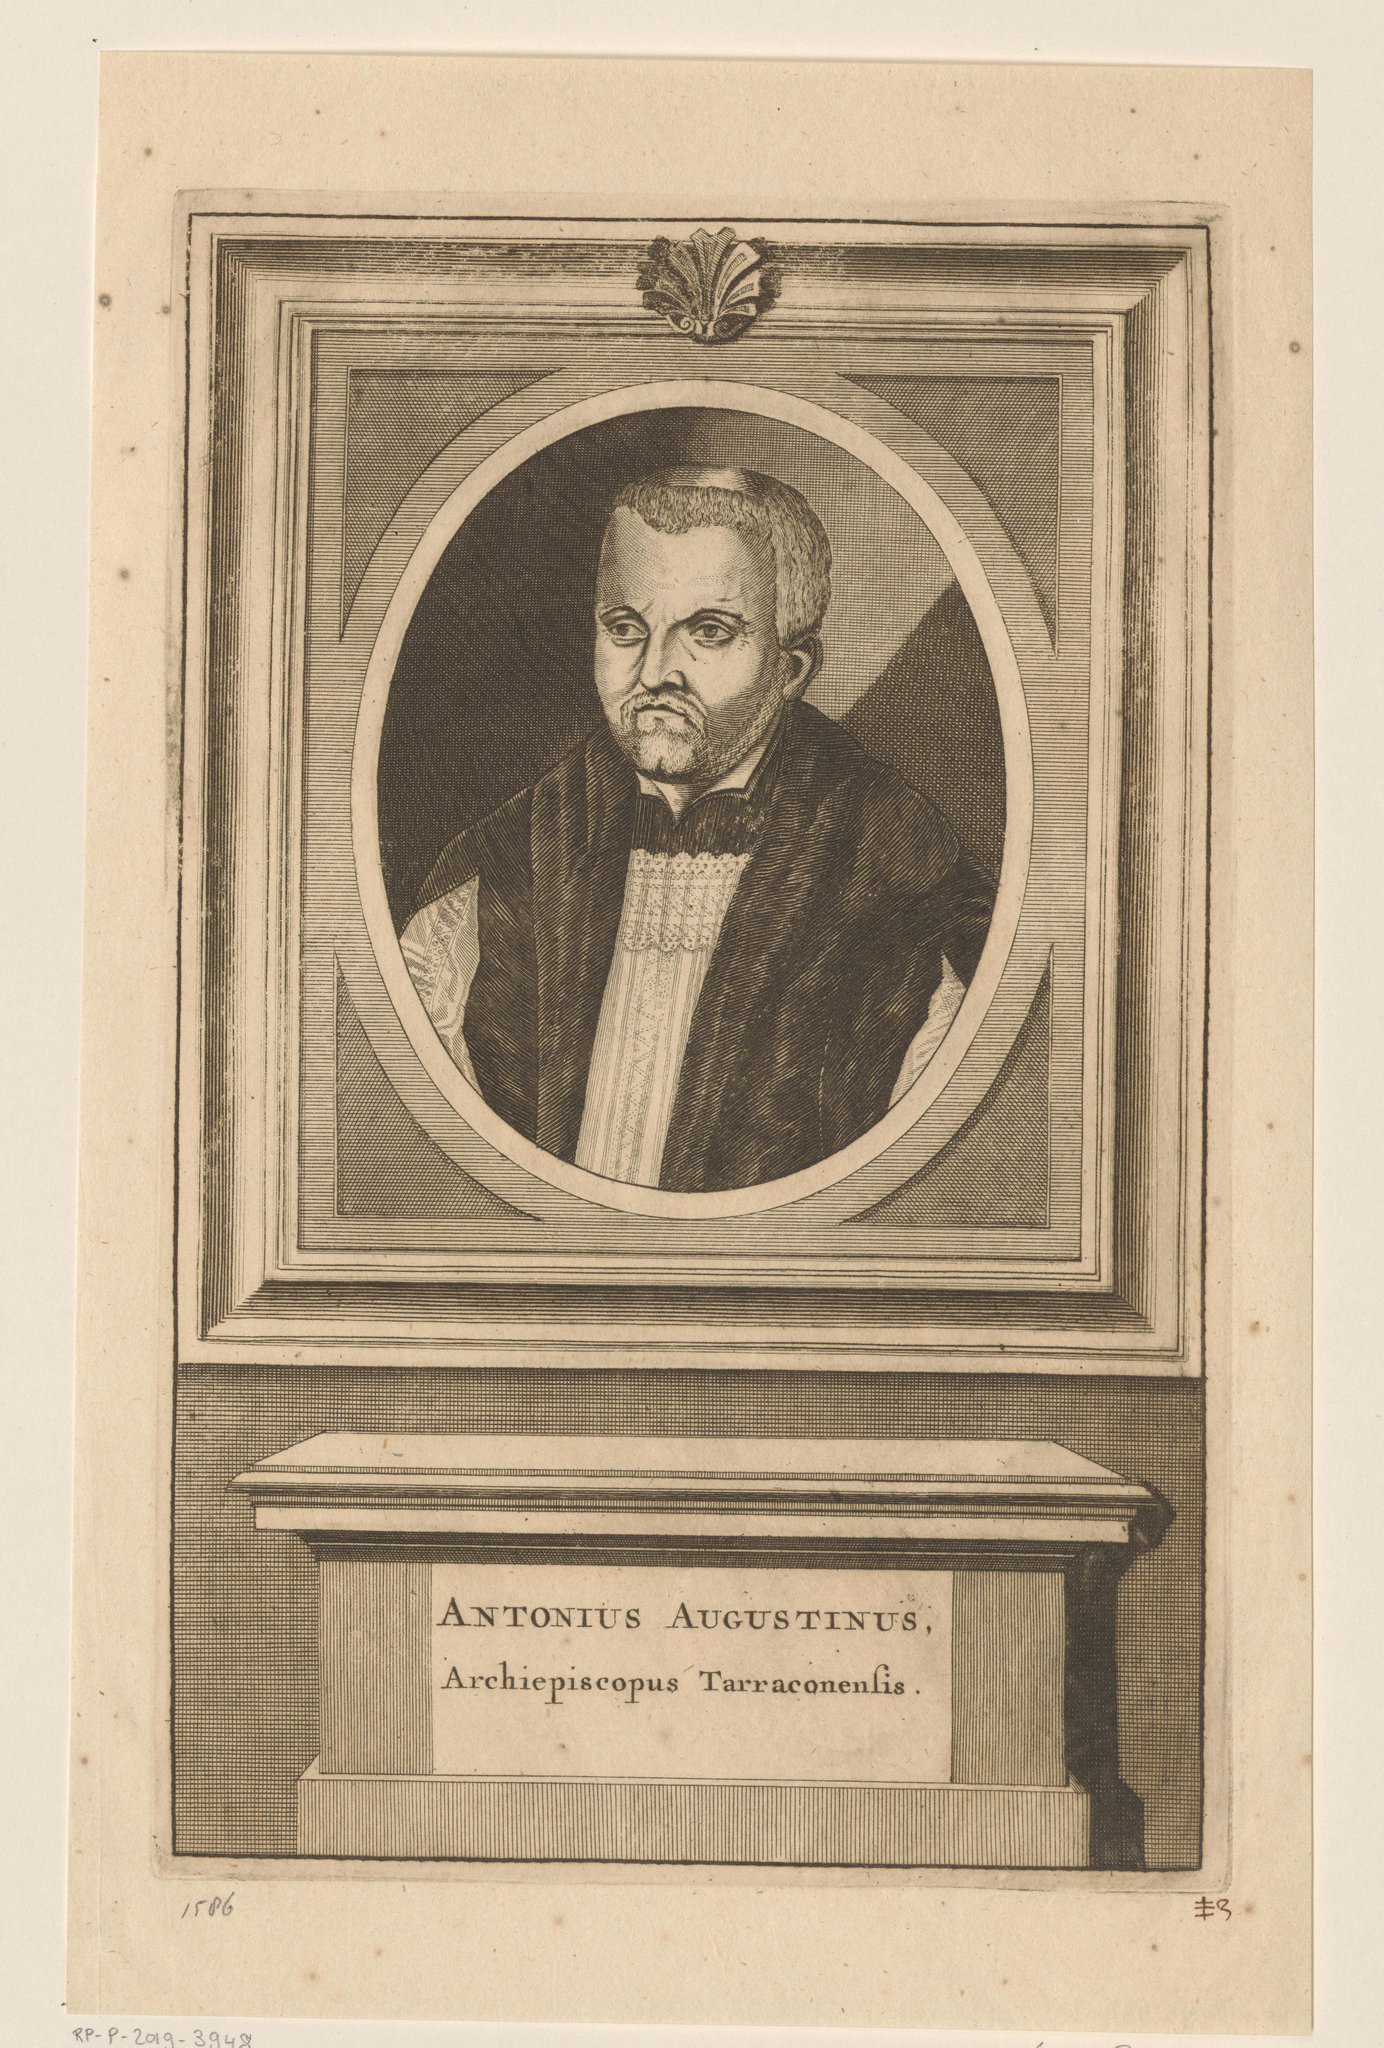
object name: print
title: Portret van Antonio Agustín, aartsbisschop van Tarragona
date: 1720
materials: paper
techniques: engraving, etching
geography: leiden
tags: historical persons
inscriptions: inscription: ‘#3’